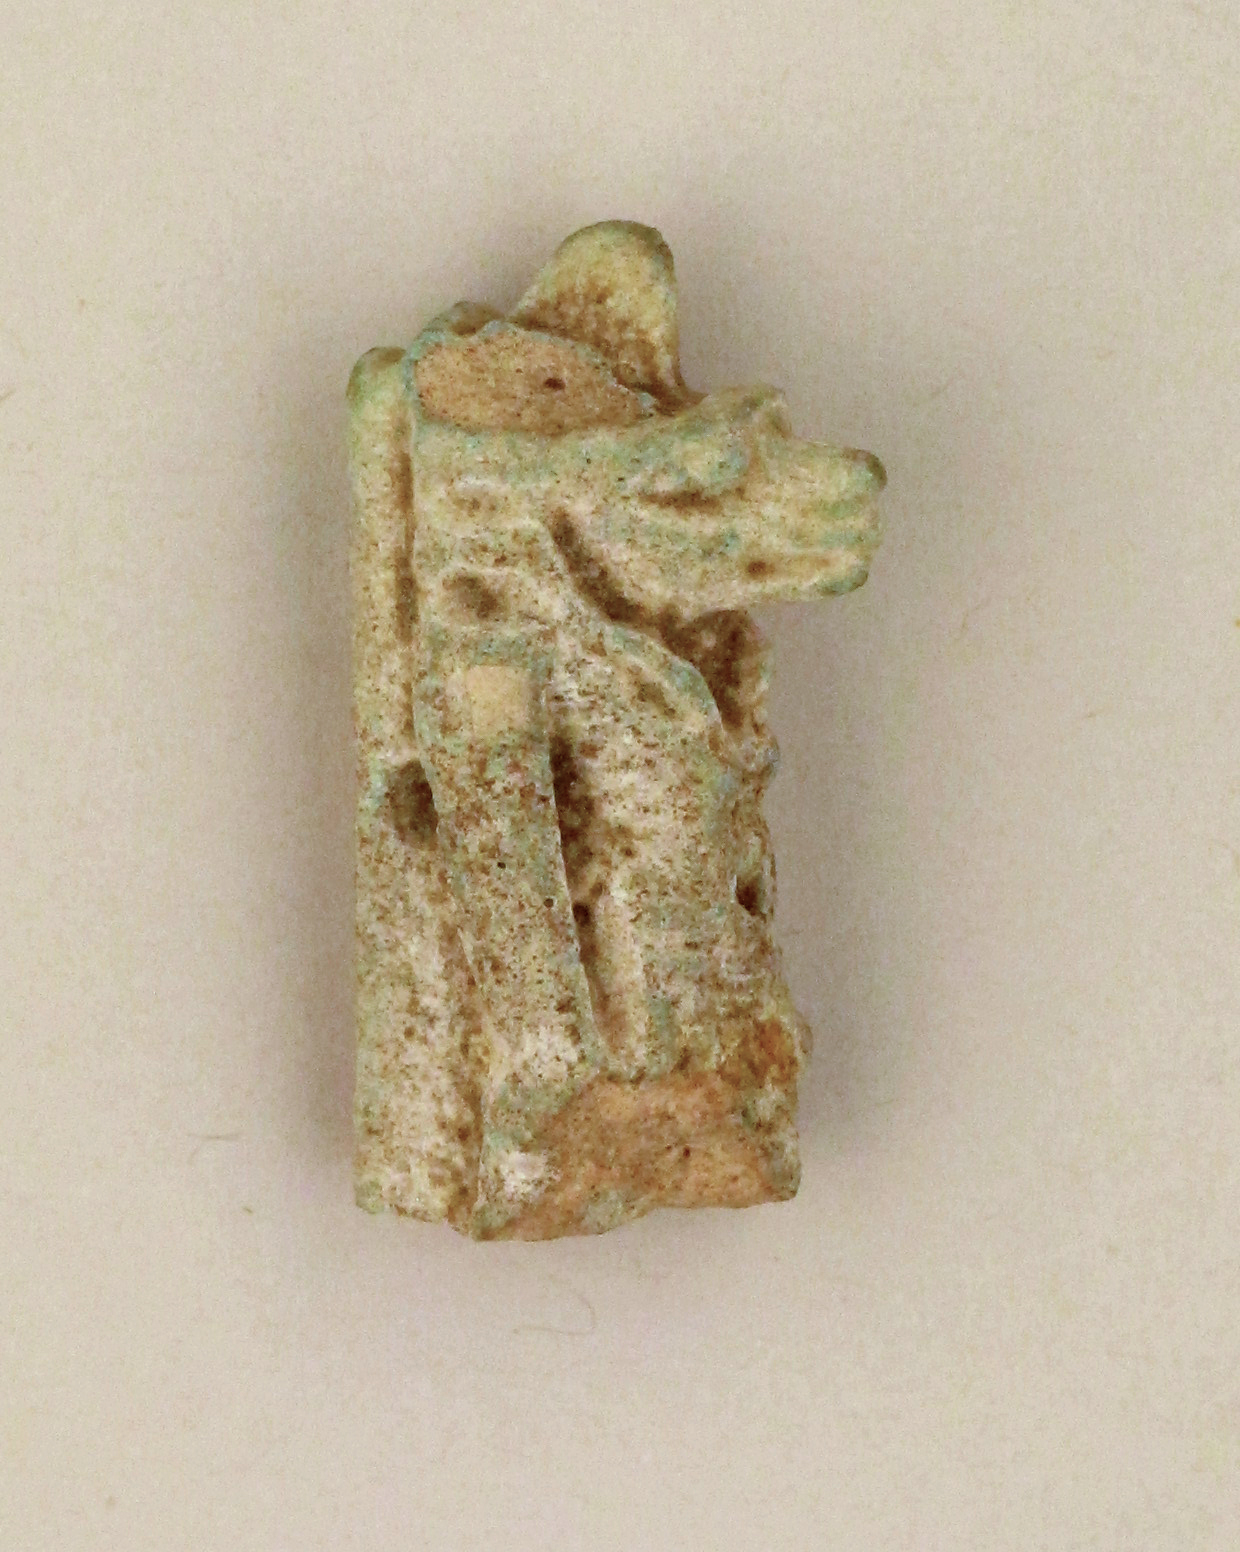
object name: amulet, anubis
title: Faience amulet of a canine-headed Anubis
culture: egyptian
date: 664-334 BCE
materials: faience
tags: anubis